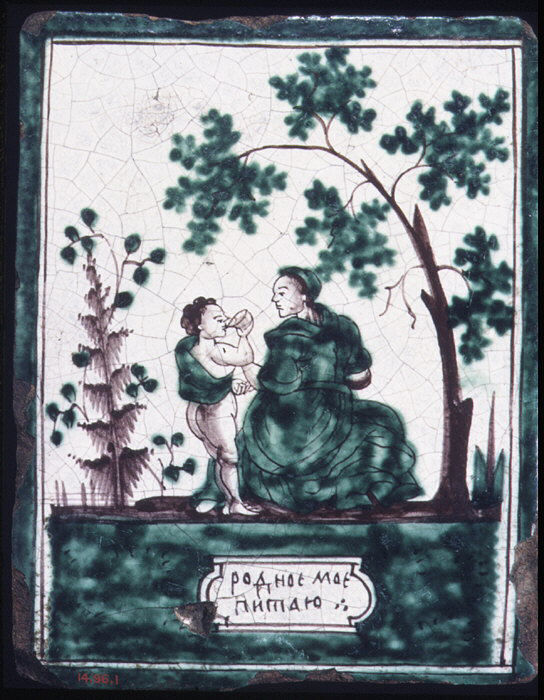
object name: stove tile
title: Hagar and Ishmael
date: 1701-1800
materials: pottery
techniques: glazing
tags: boys,women,trees